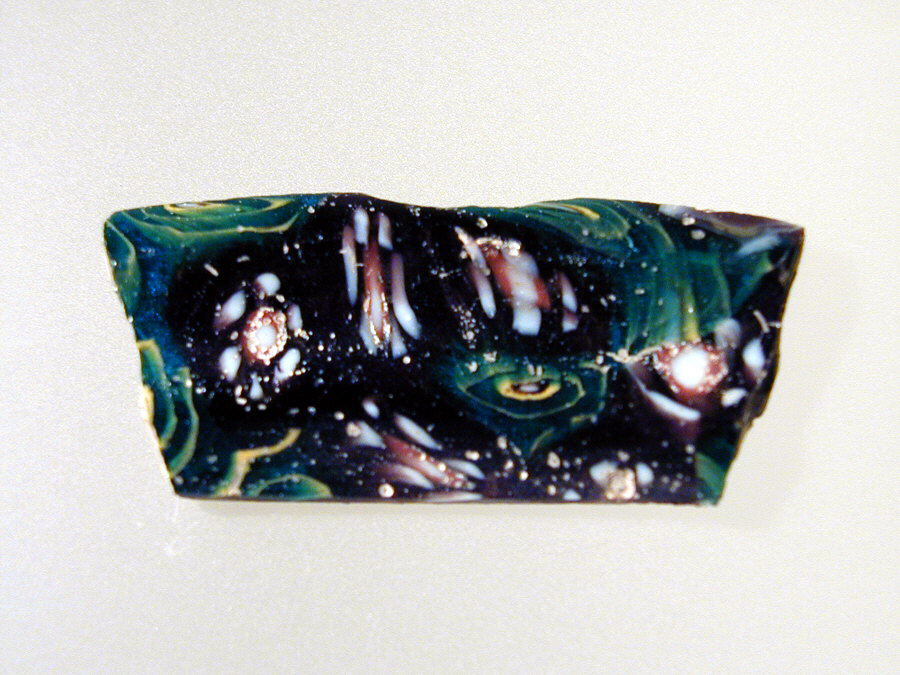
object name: fragment, mosaic dish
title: Glass mosaic carinated dish fragment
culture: roman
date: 34 BCE-33 CE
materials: glass